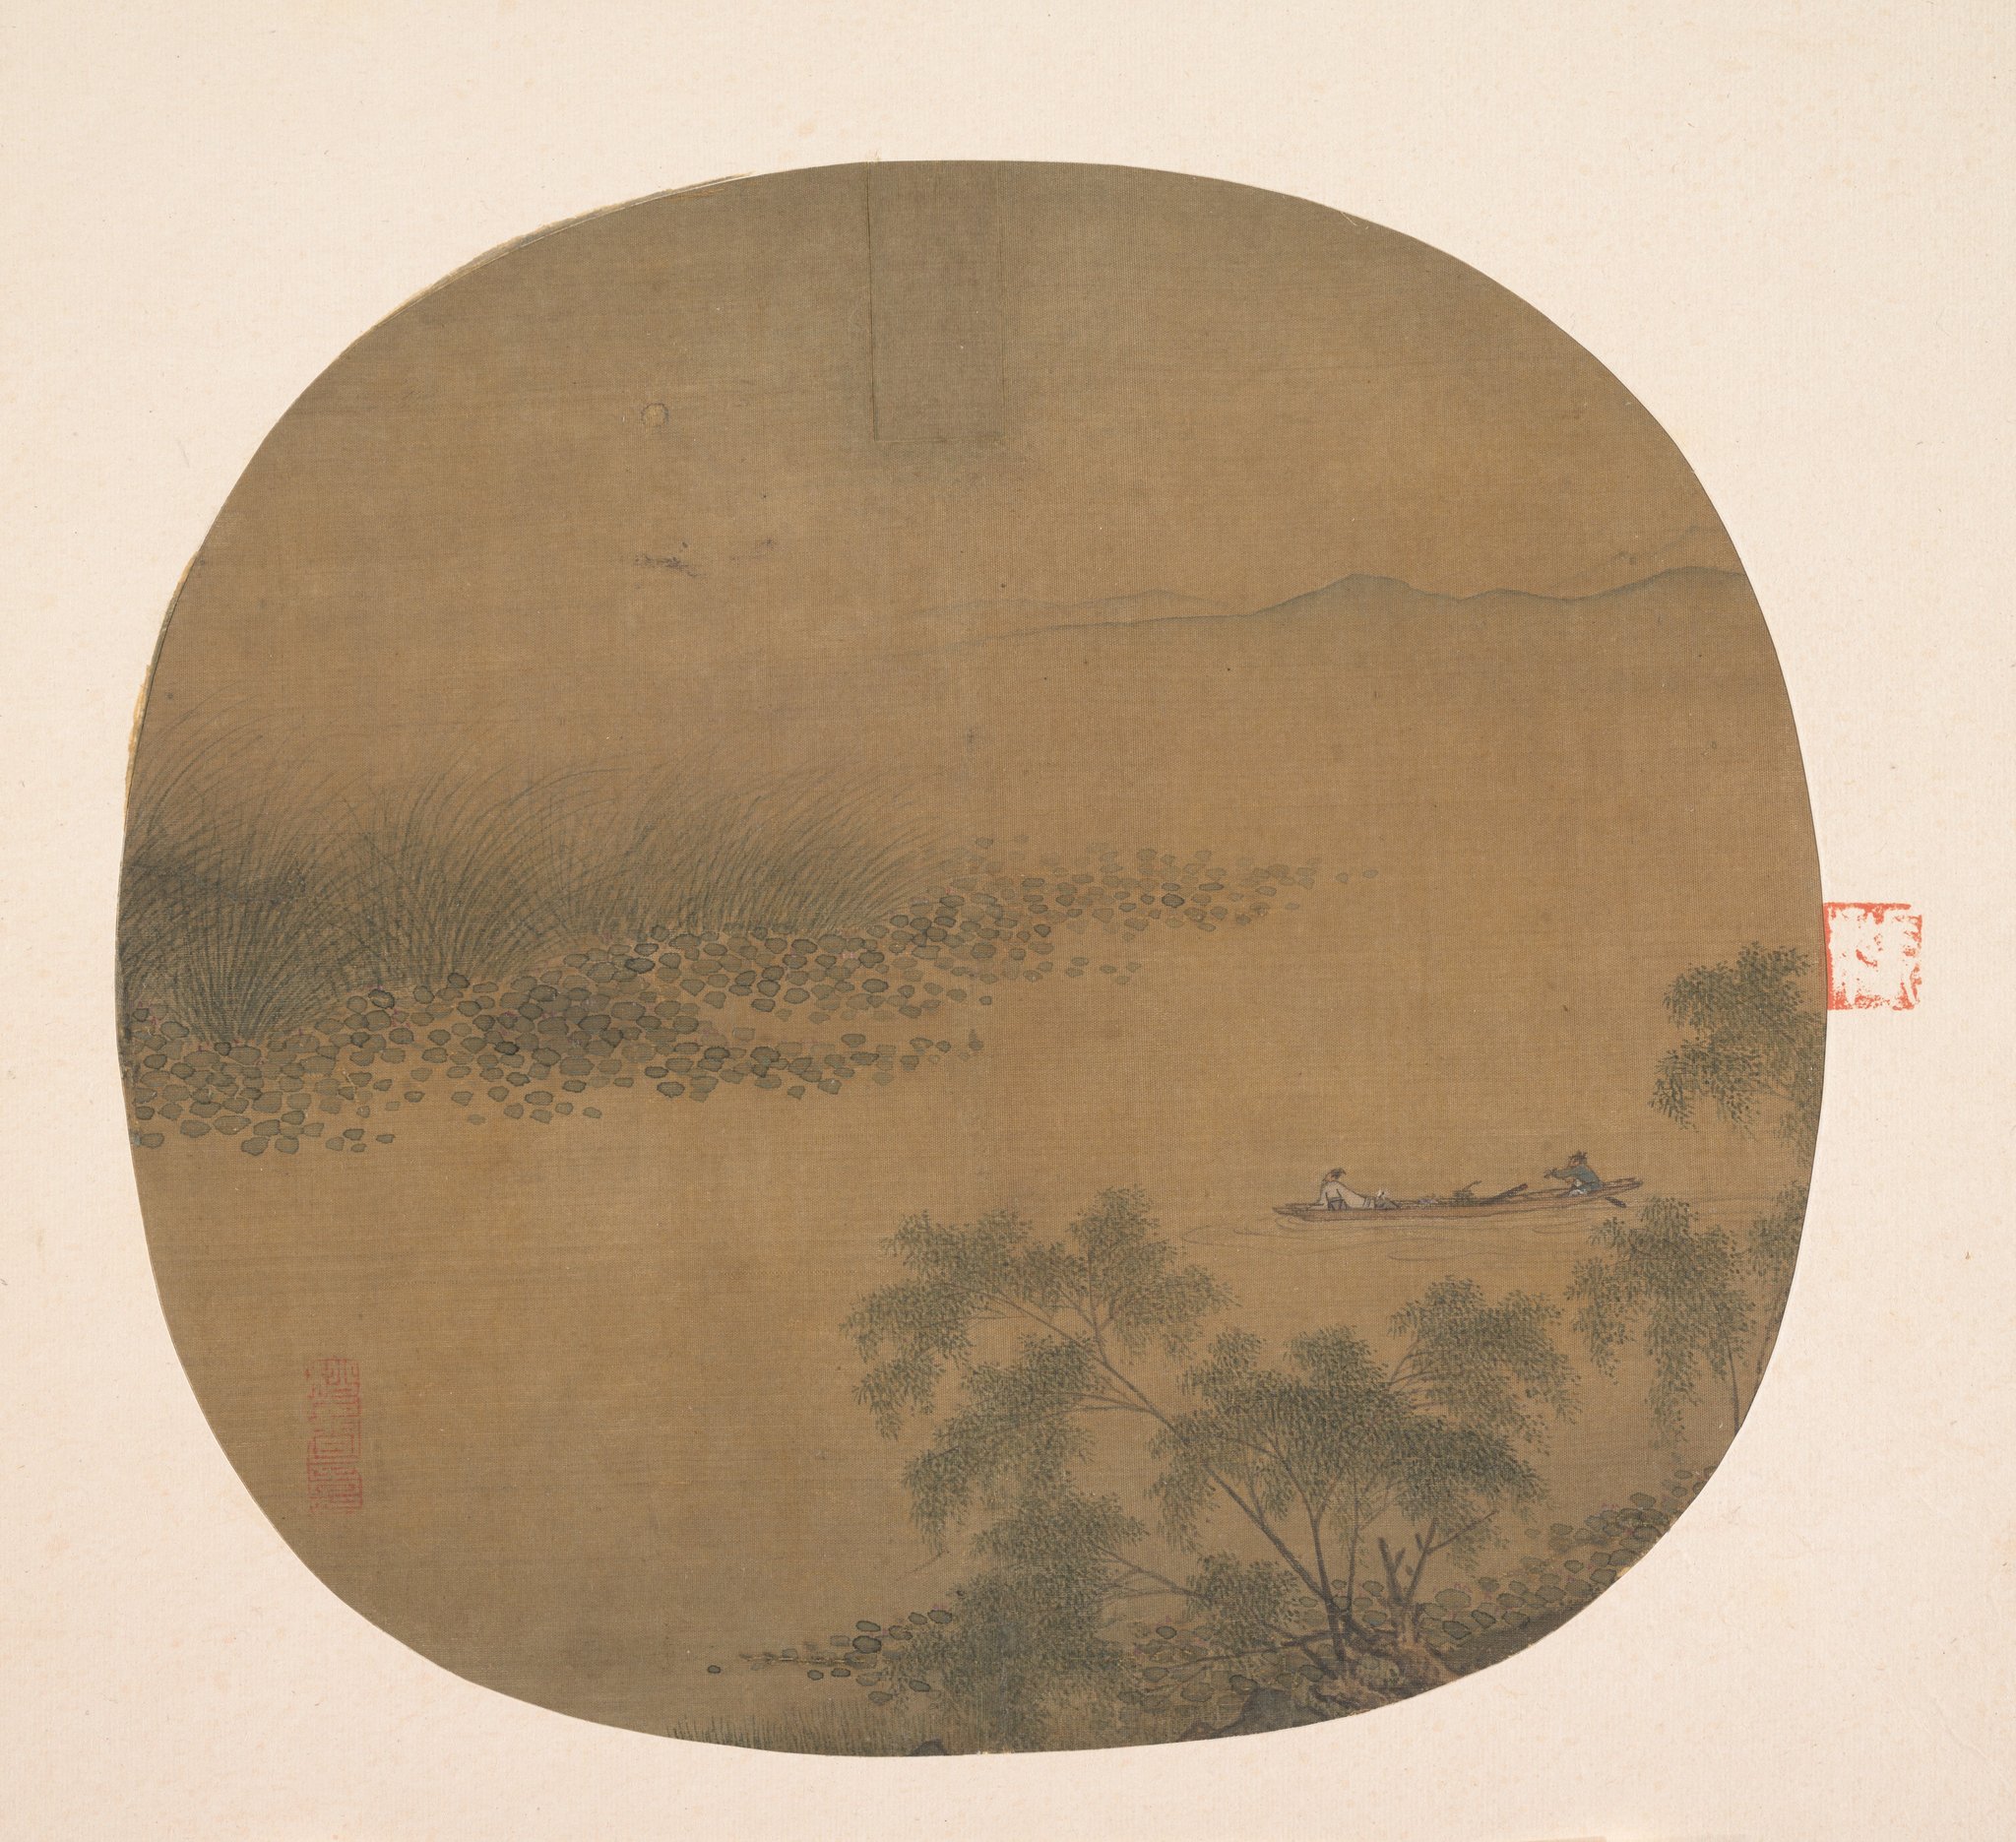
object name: fan mounted a an album leaf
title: Boating by a Willow Bank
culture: chinese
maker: unidentified artist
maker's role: artist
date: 1201-1300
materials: ink, silk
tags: rivers,landscapes,boats